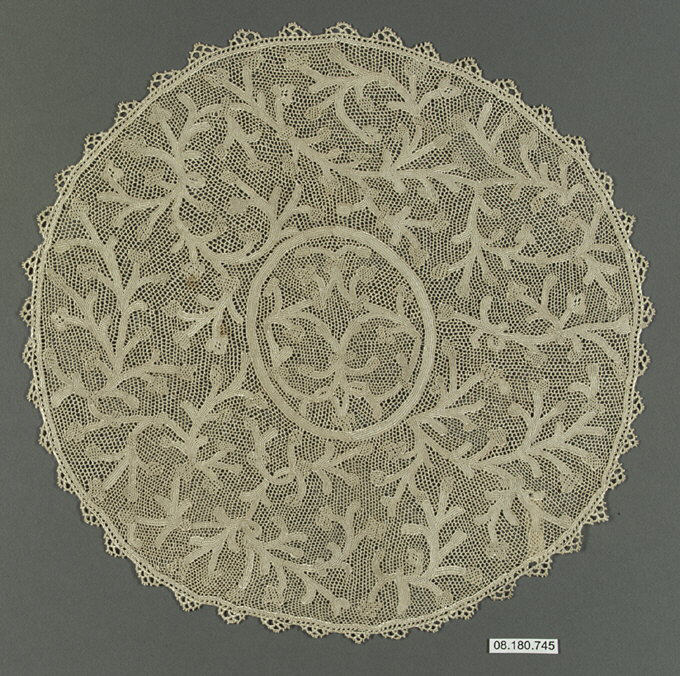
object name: mat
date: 1801-1900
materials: silk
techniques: lace